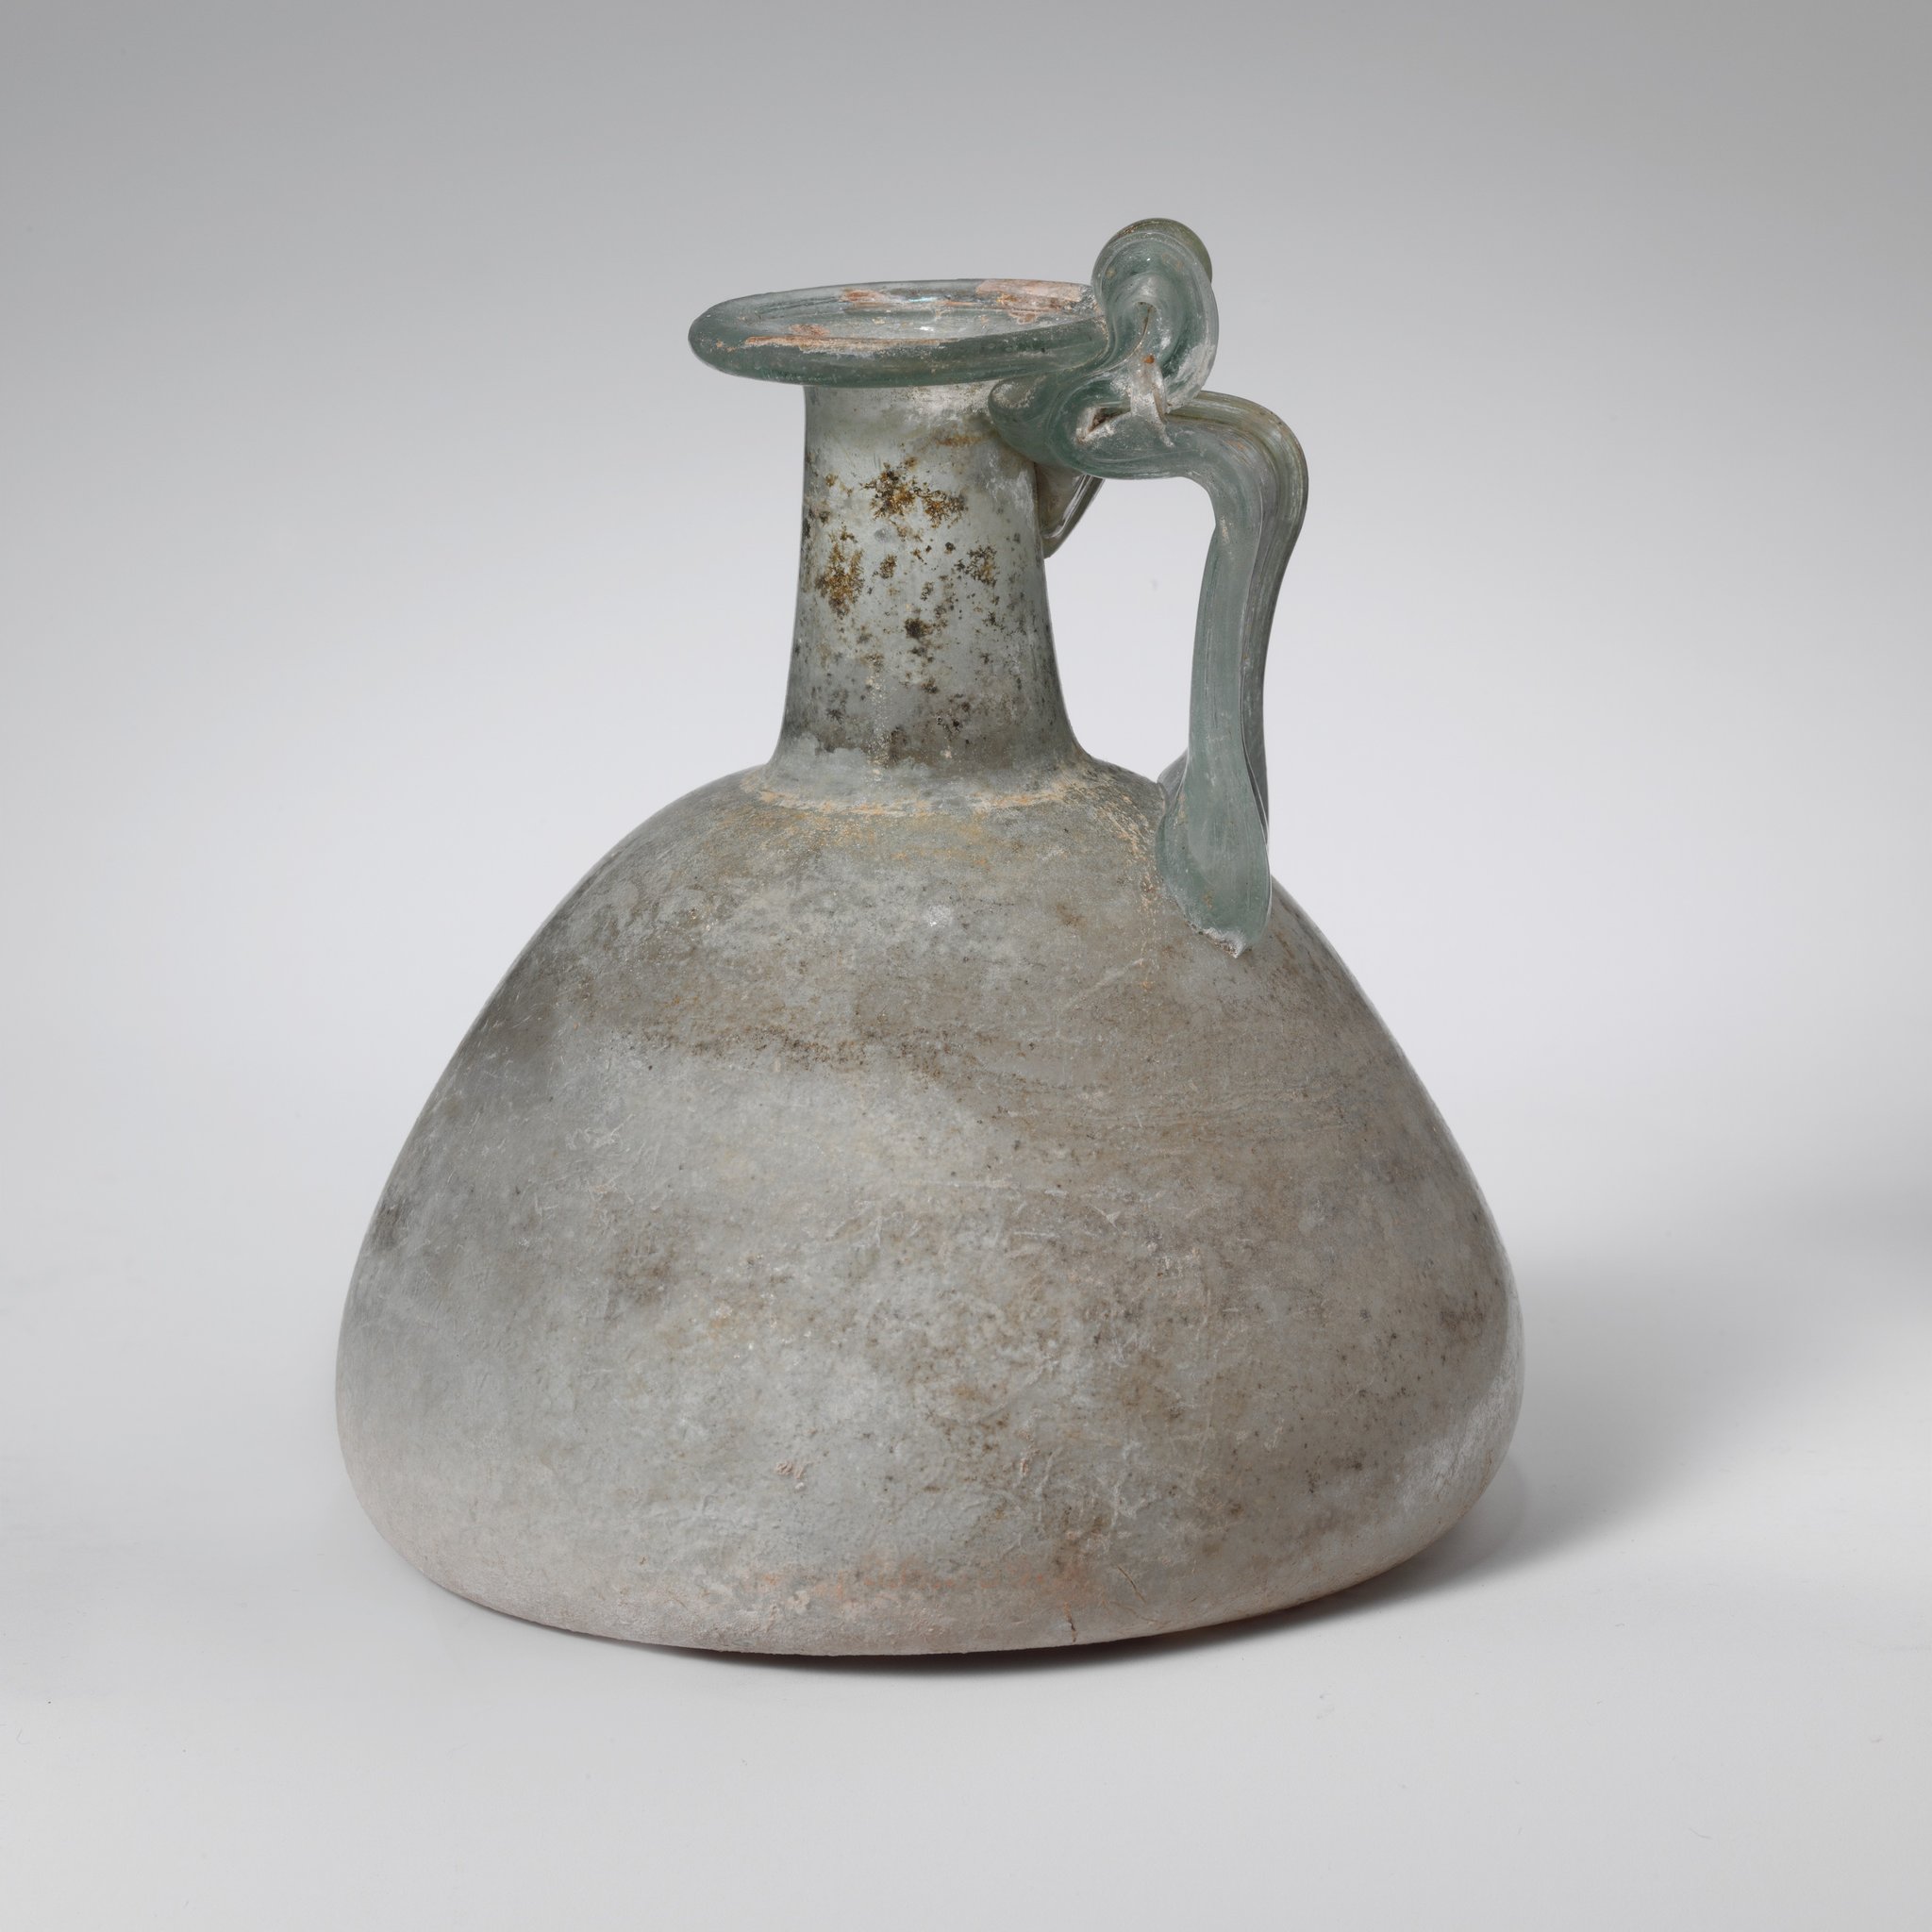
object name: jug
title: Glass jug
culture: roman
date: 101-300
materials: glass